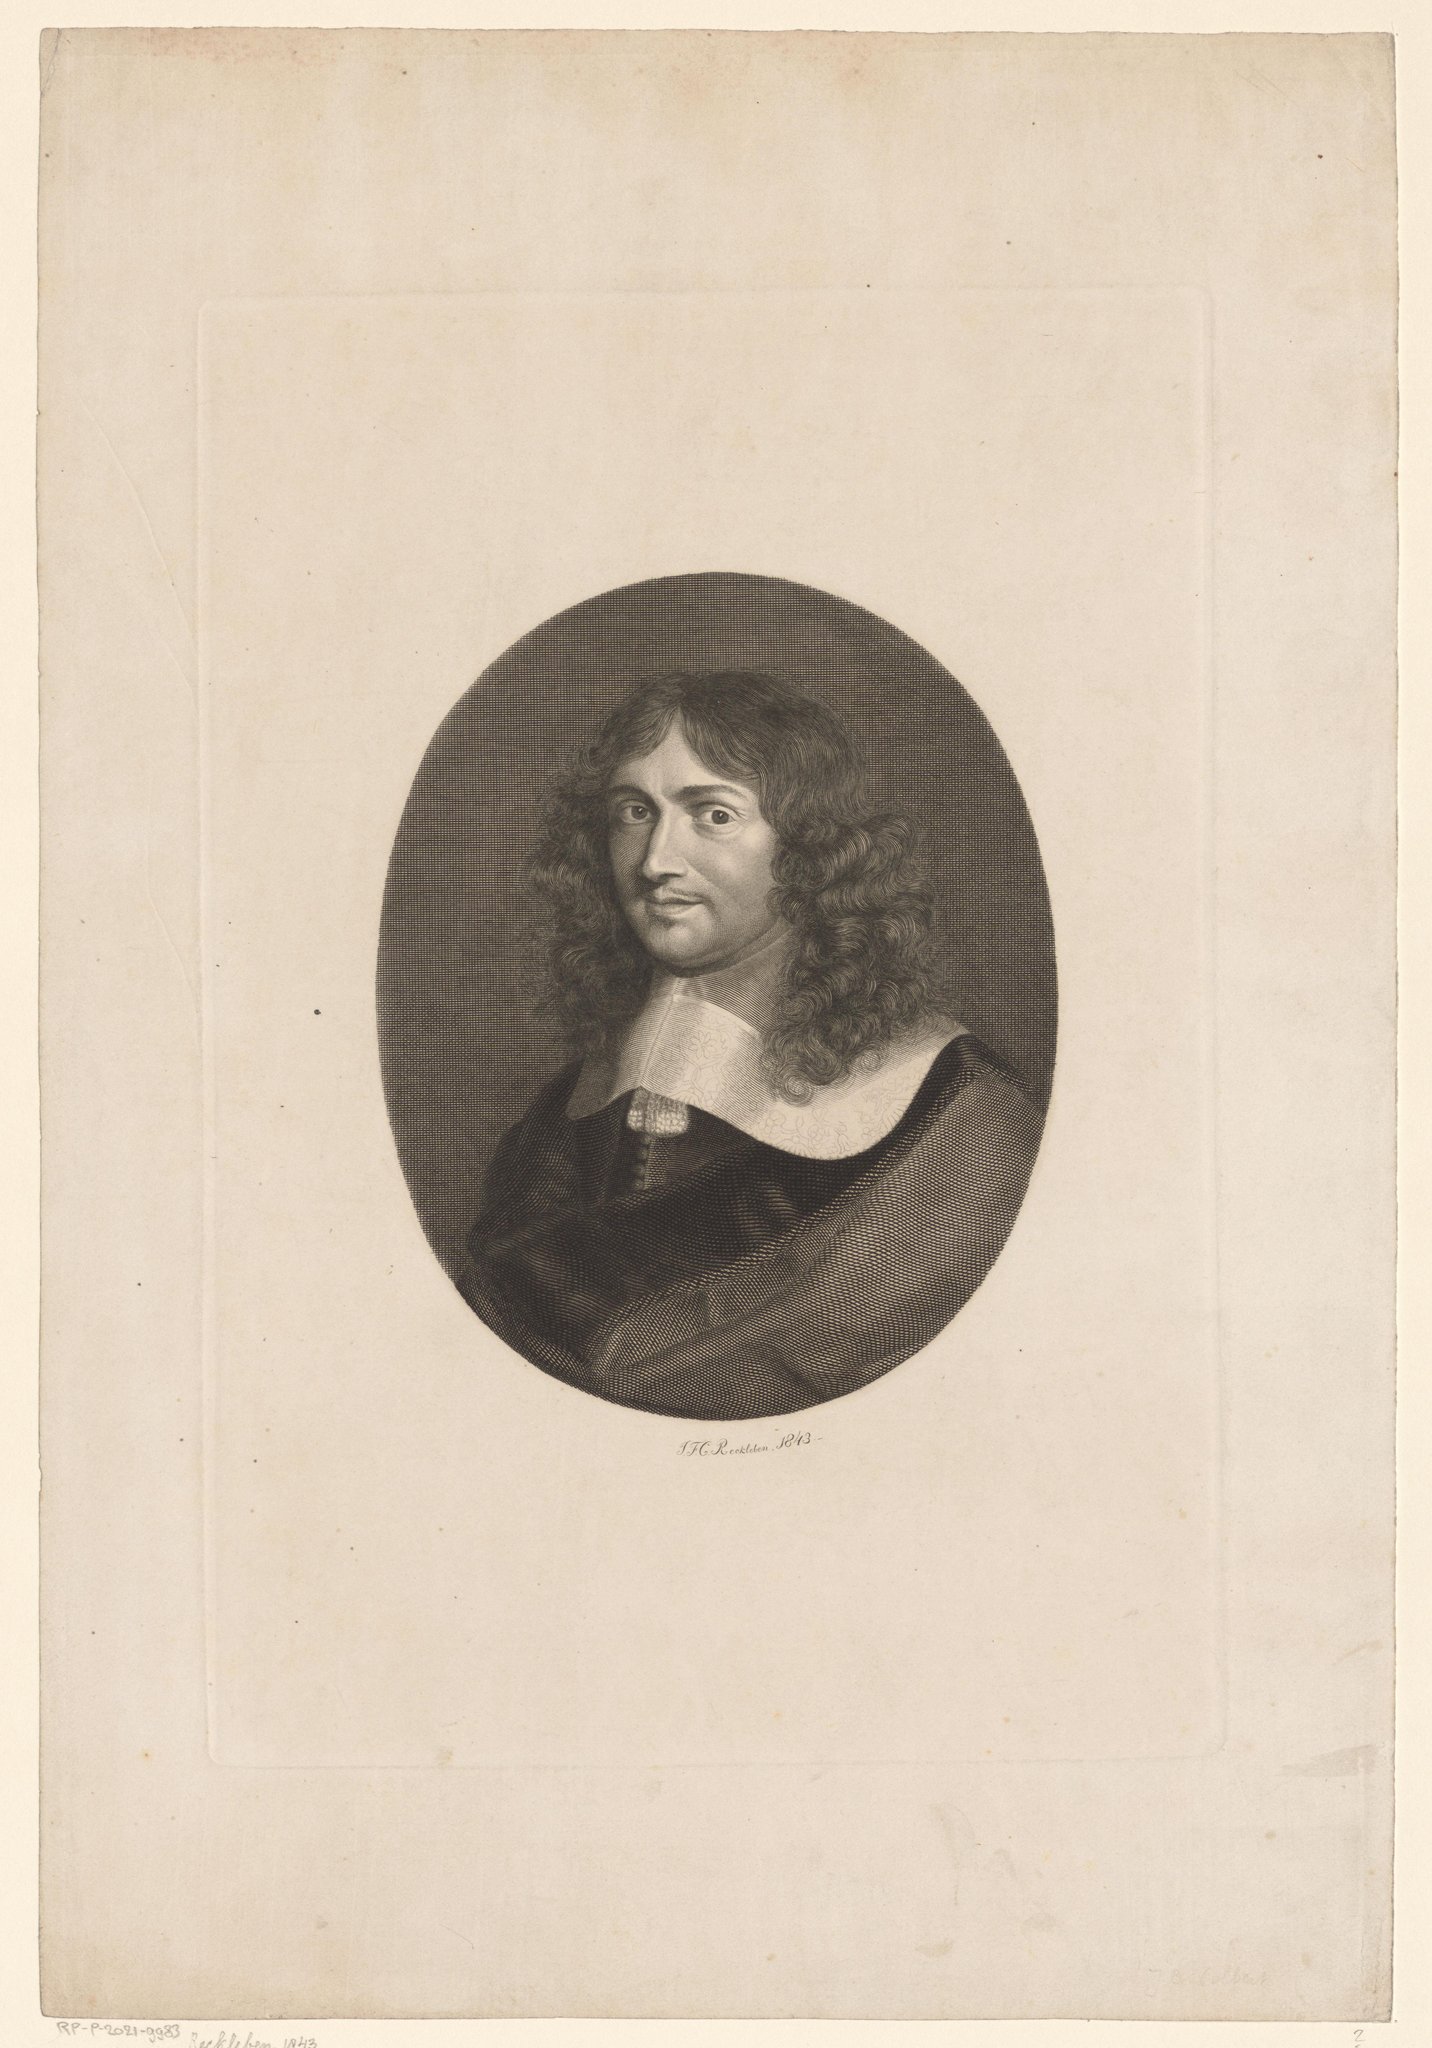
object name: print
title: Portret van Jean-Baptiste Colbert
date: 1843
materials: paper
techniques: engraving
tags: paris, politician, jean-baptiste colbert, historical persons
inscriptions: collector's mark: Lugt 2228